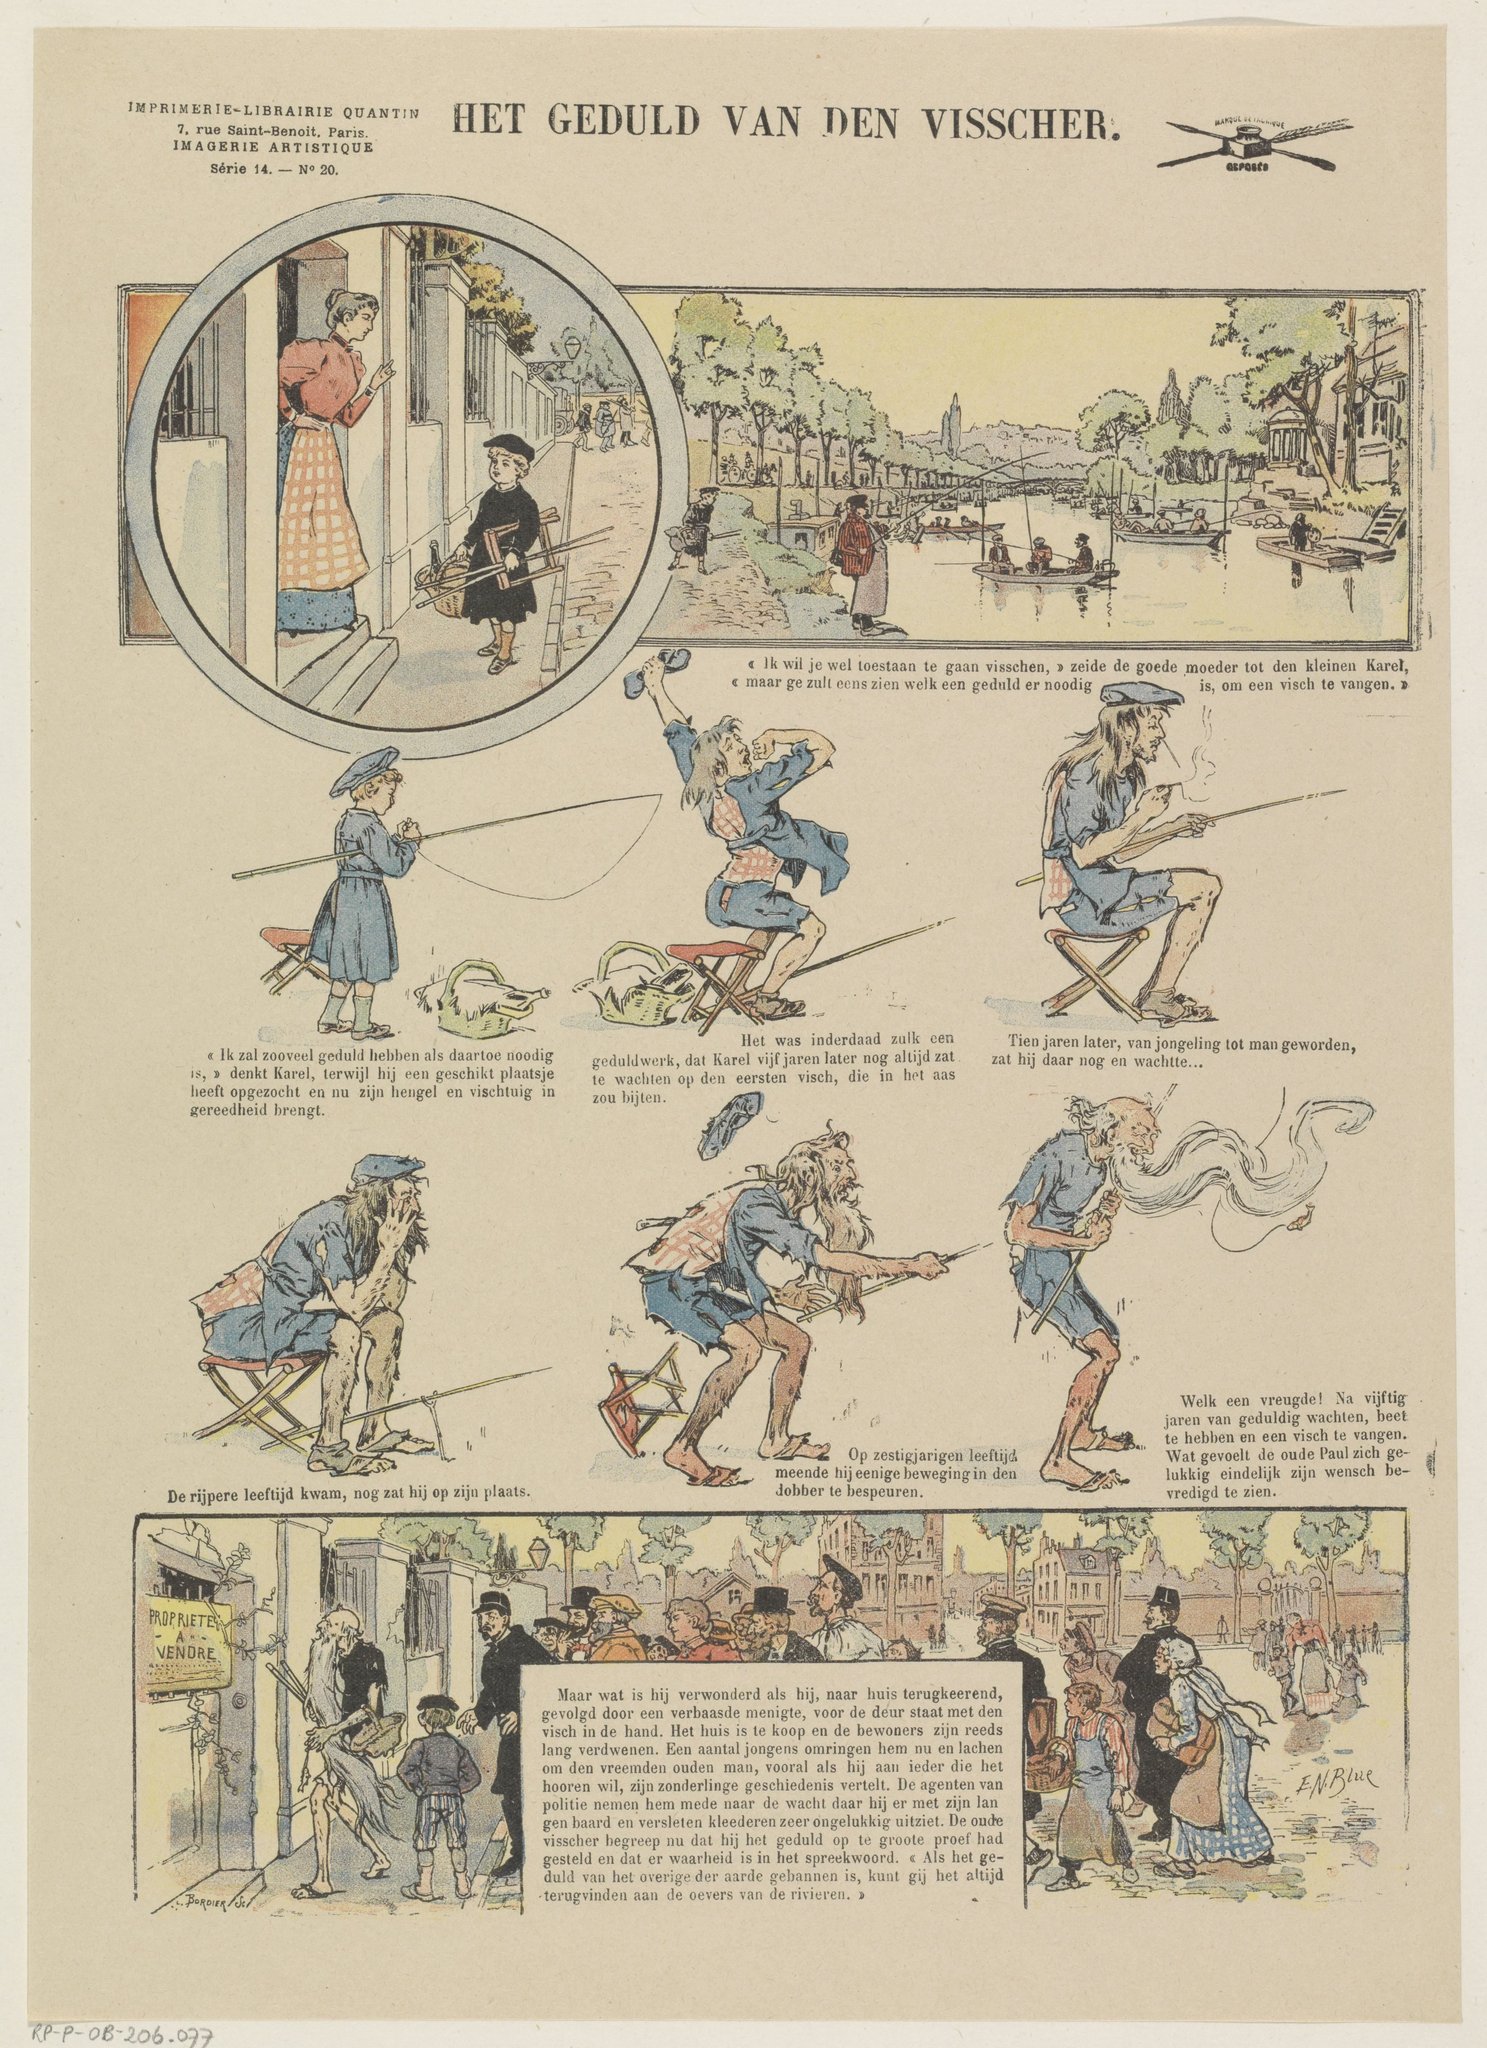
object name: popular print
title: Het geduld van den visscher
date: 1876-1890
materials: paper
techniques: lithograph, letterpress printing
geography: paris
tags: fishing (sports), tales and fairy tales, fisherman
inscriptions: collector's mark: Lugt 2760, : ‘marque de fabrique / deposée’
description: Blad met 4 rijen met voorstellingen van Karel die gaat vissen. Zijn moeder zegt dat hij daarvoor geduld moet hebben. Karel zit vijftig jaar later nog aan de waterkant. Onder elke afbeelding een onderschrift. Genummerd linksboven: Série 14. - No. 20.